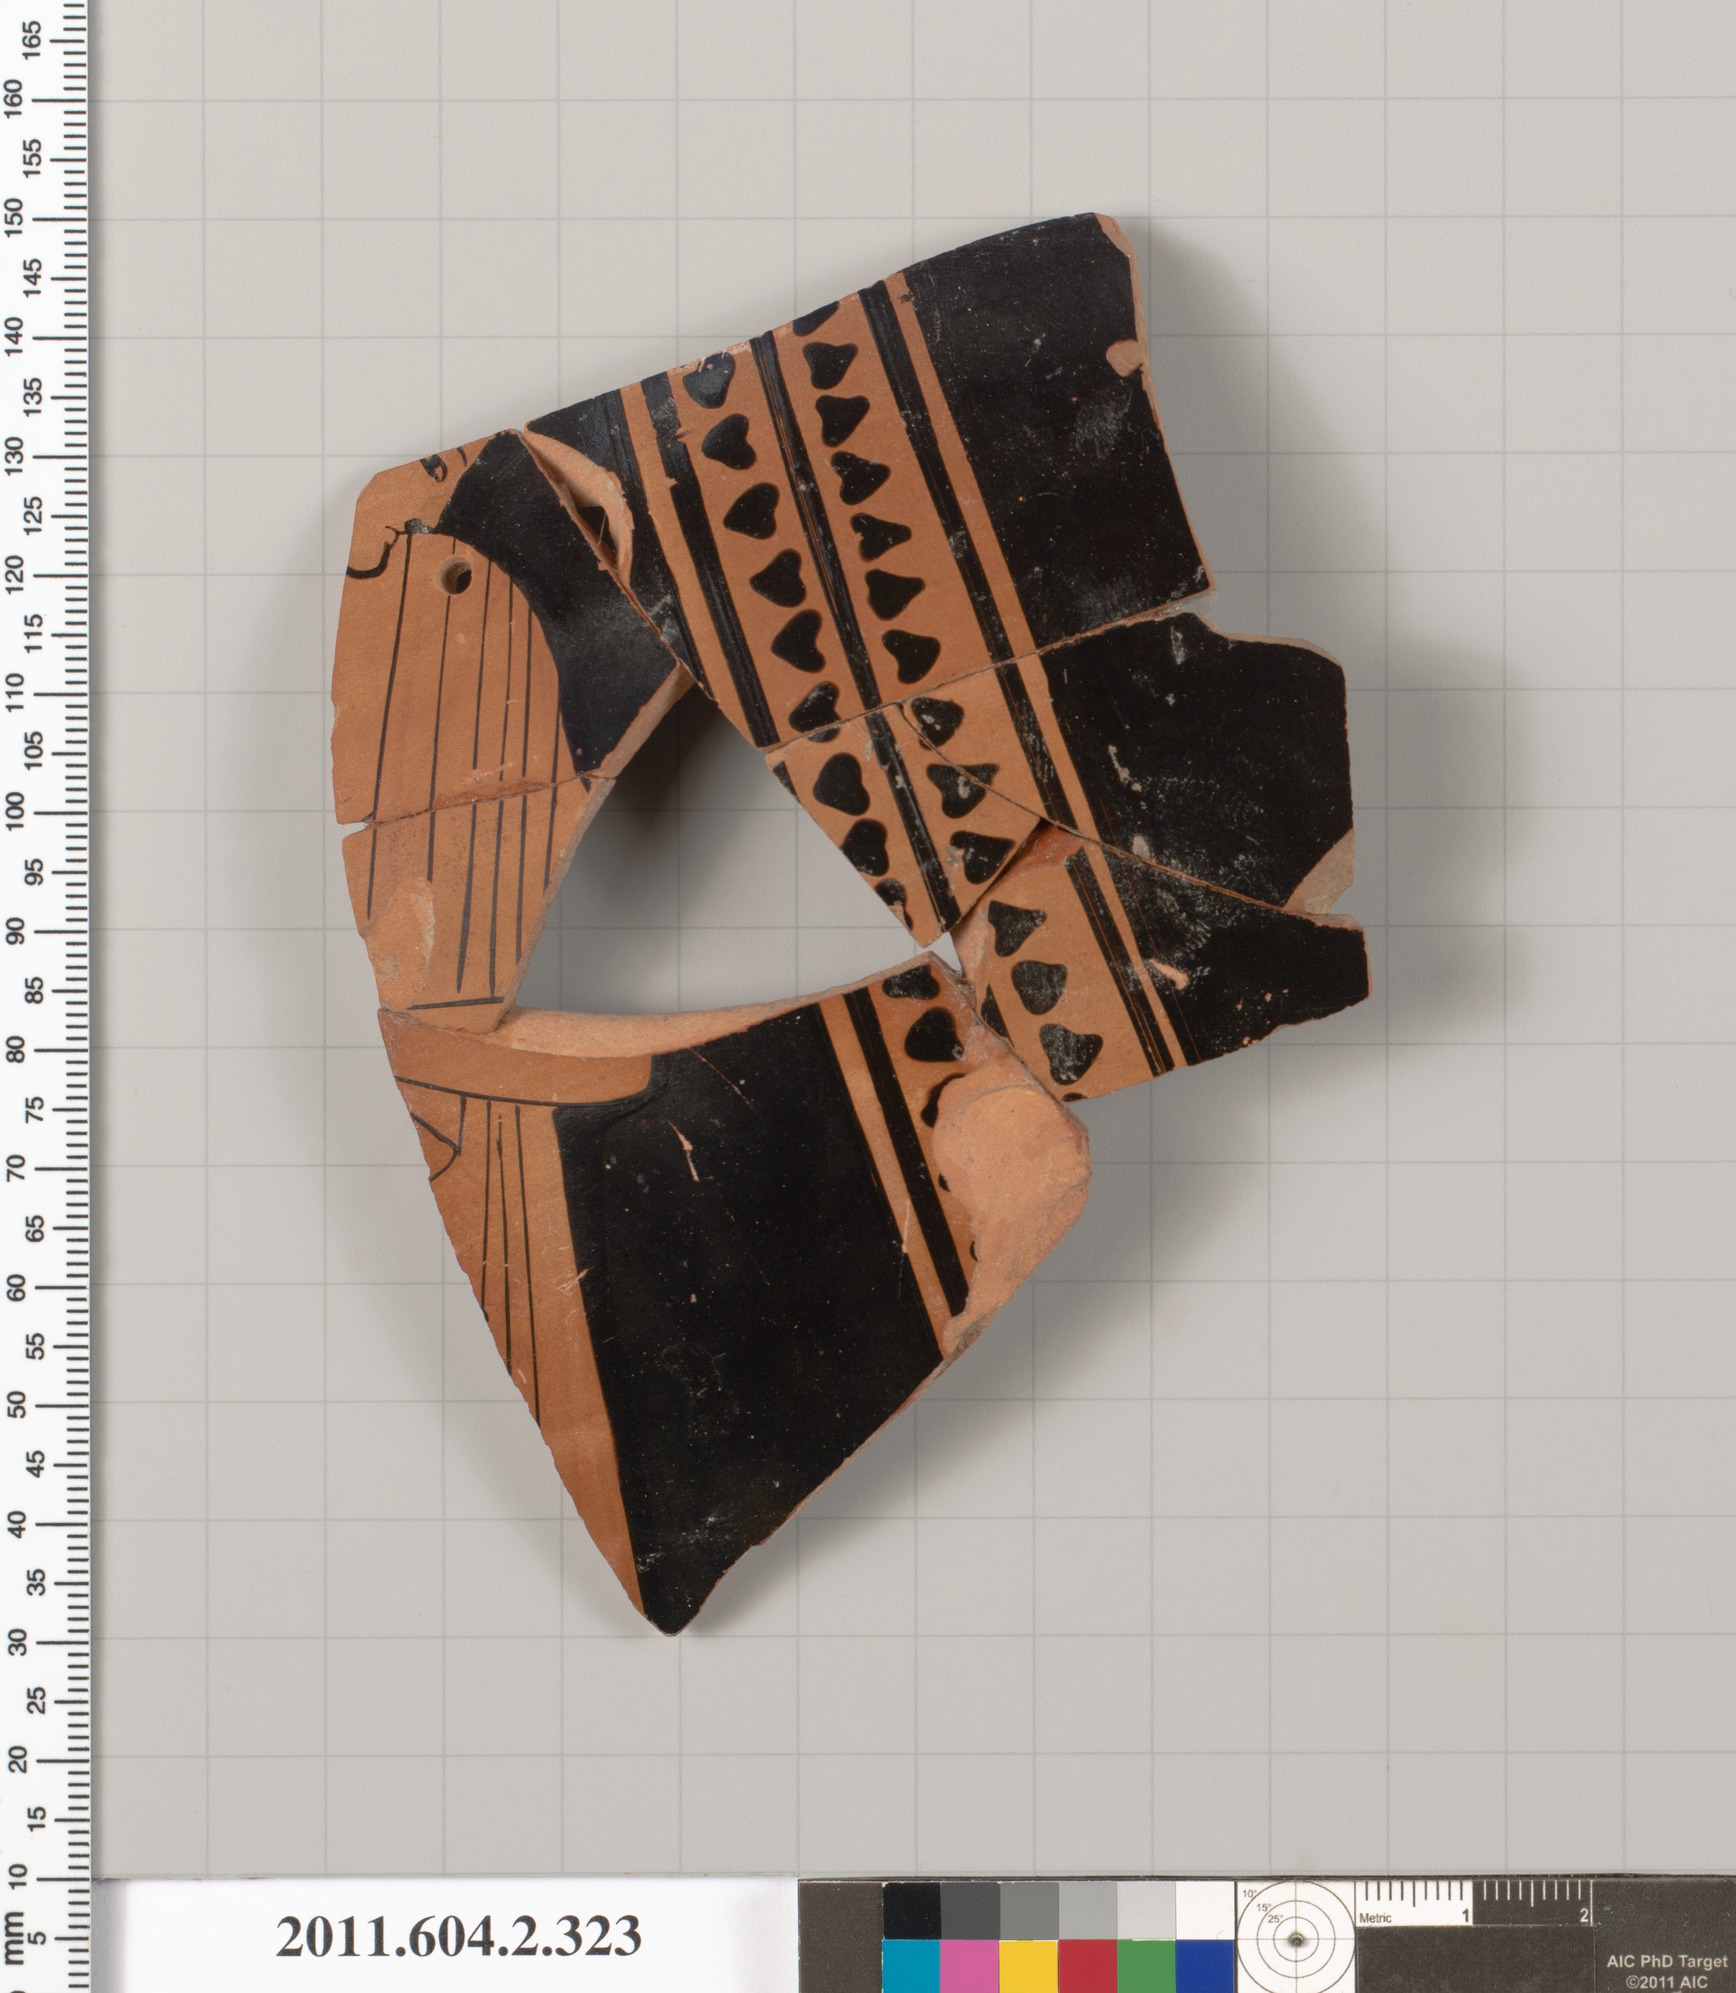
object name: column krater fragment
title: Terracotta fragment of a column-krater (bowl for mixing wine and water)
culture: greek, attic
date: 475-451 BCE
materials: terracotta